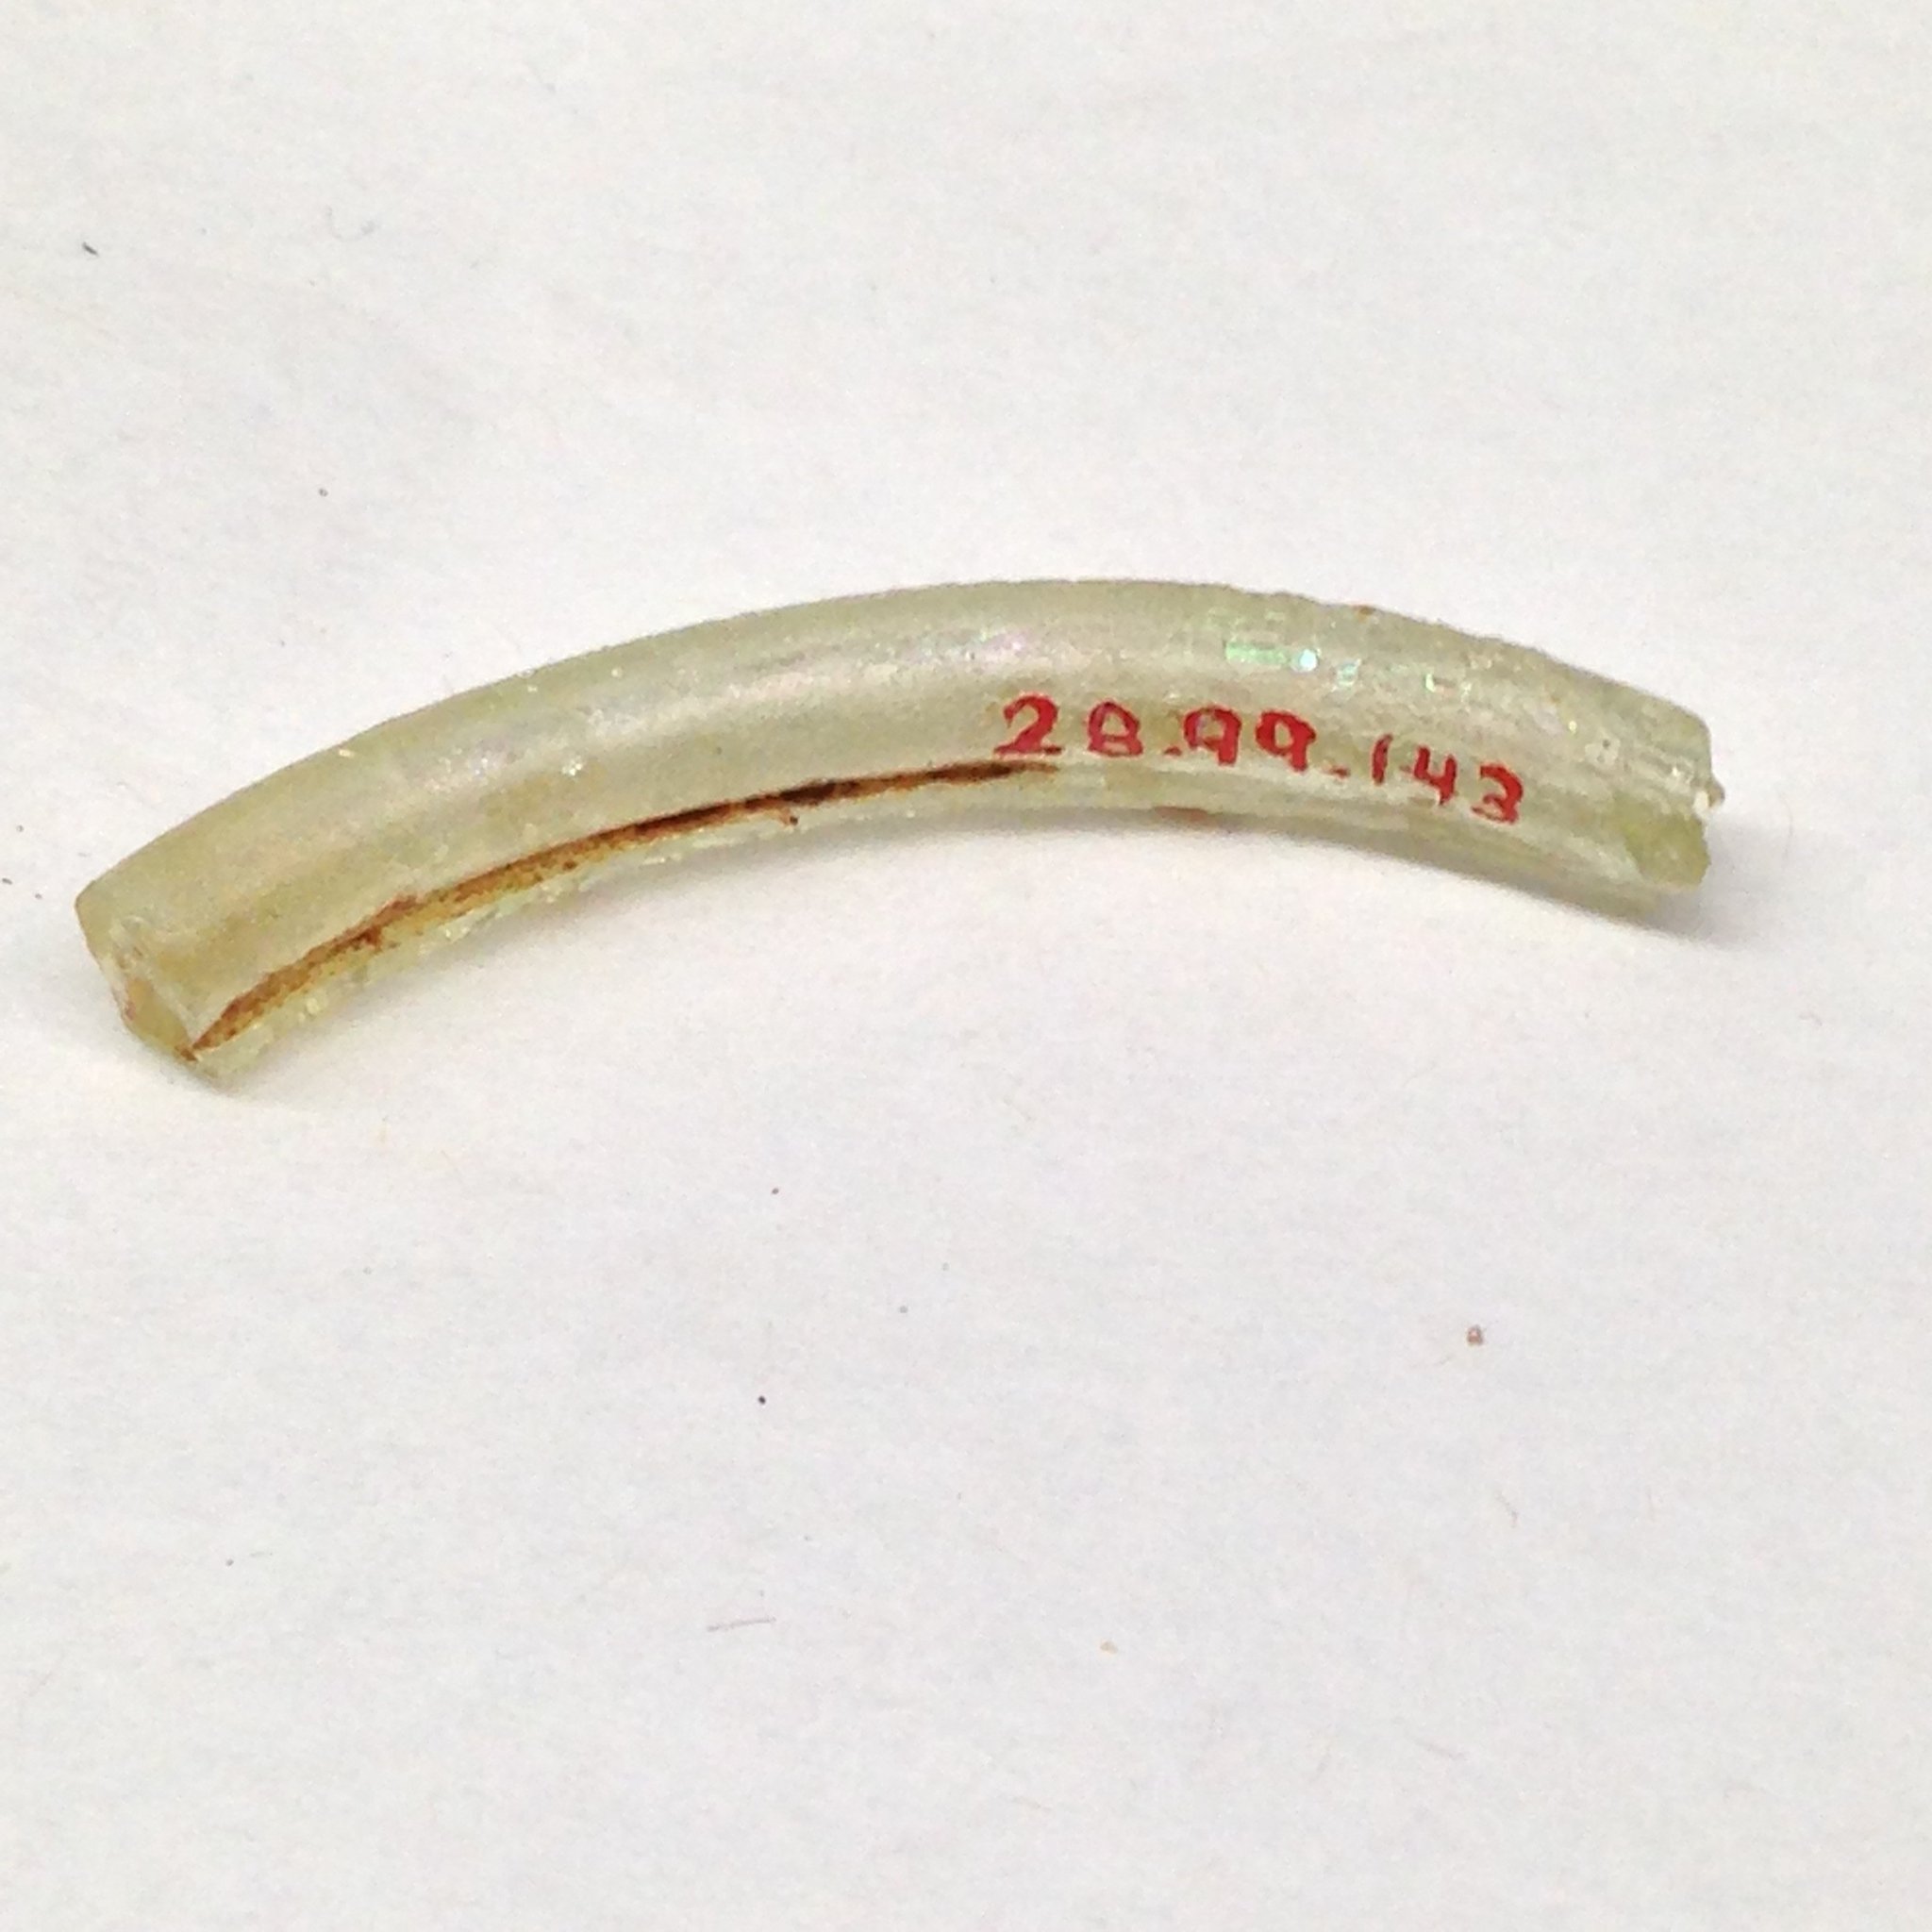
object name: fragment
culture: european or middle eastern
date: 1150-1250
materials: ceramic, glass